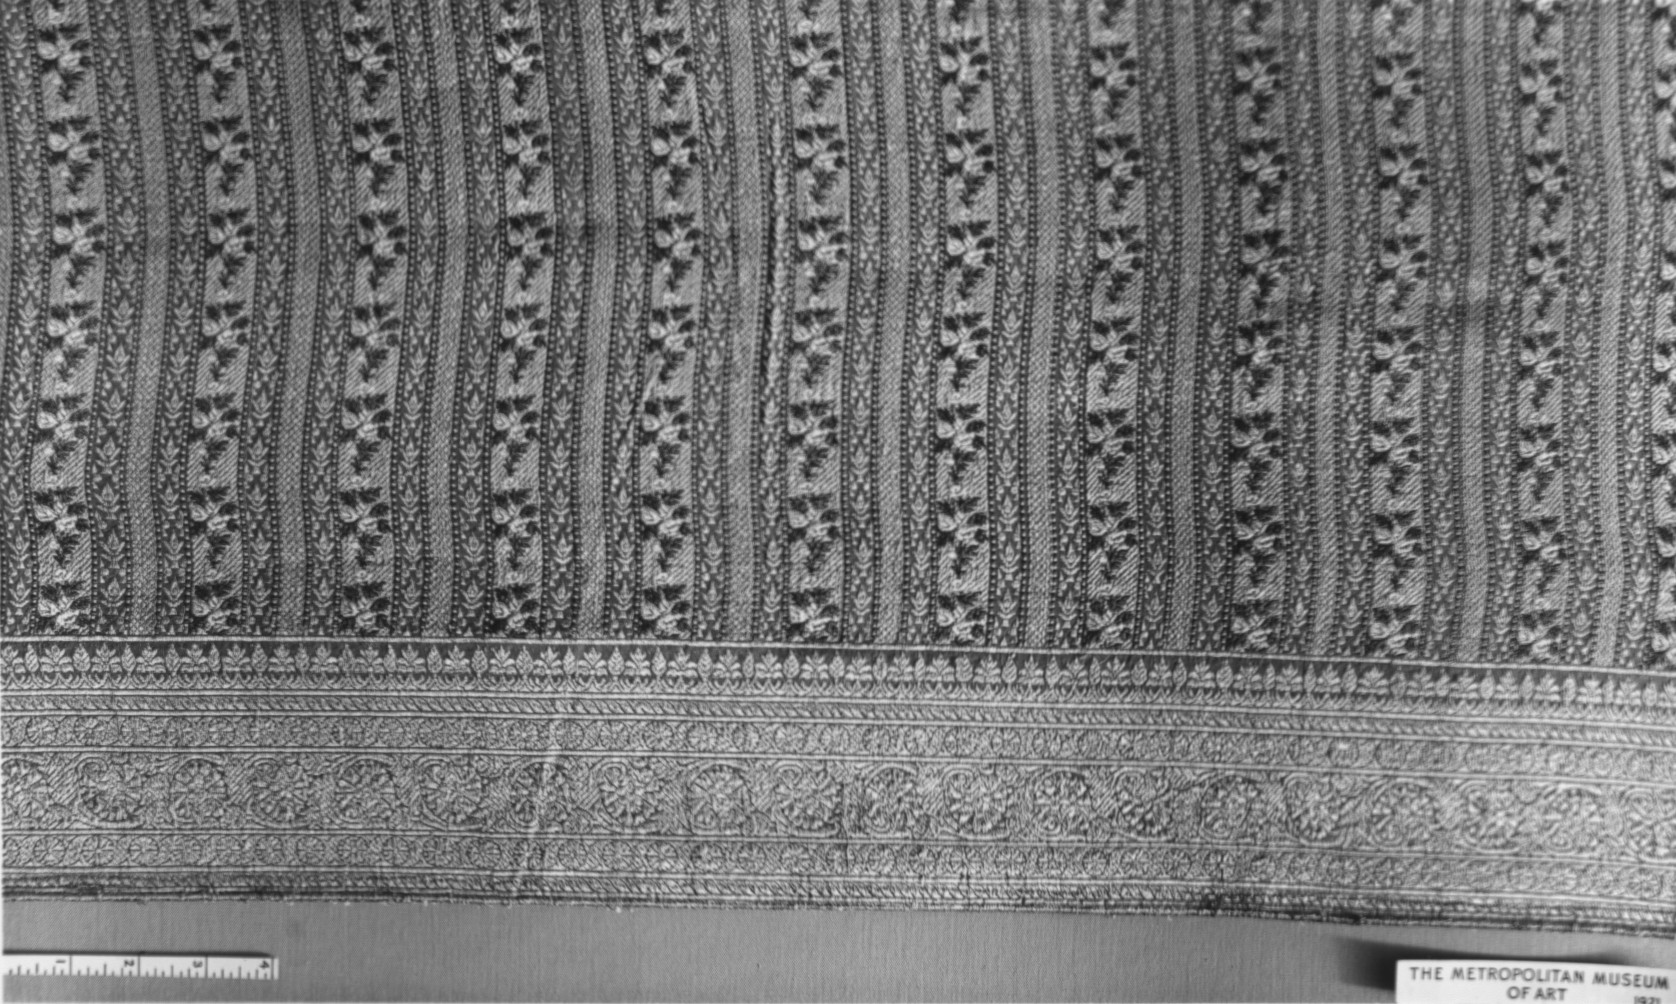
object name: panel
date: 1701-1800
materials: metal thread, silk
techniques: brocade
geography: india